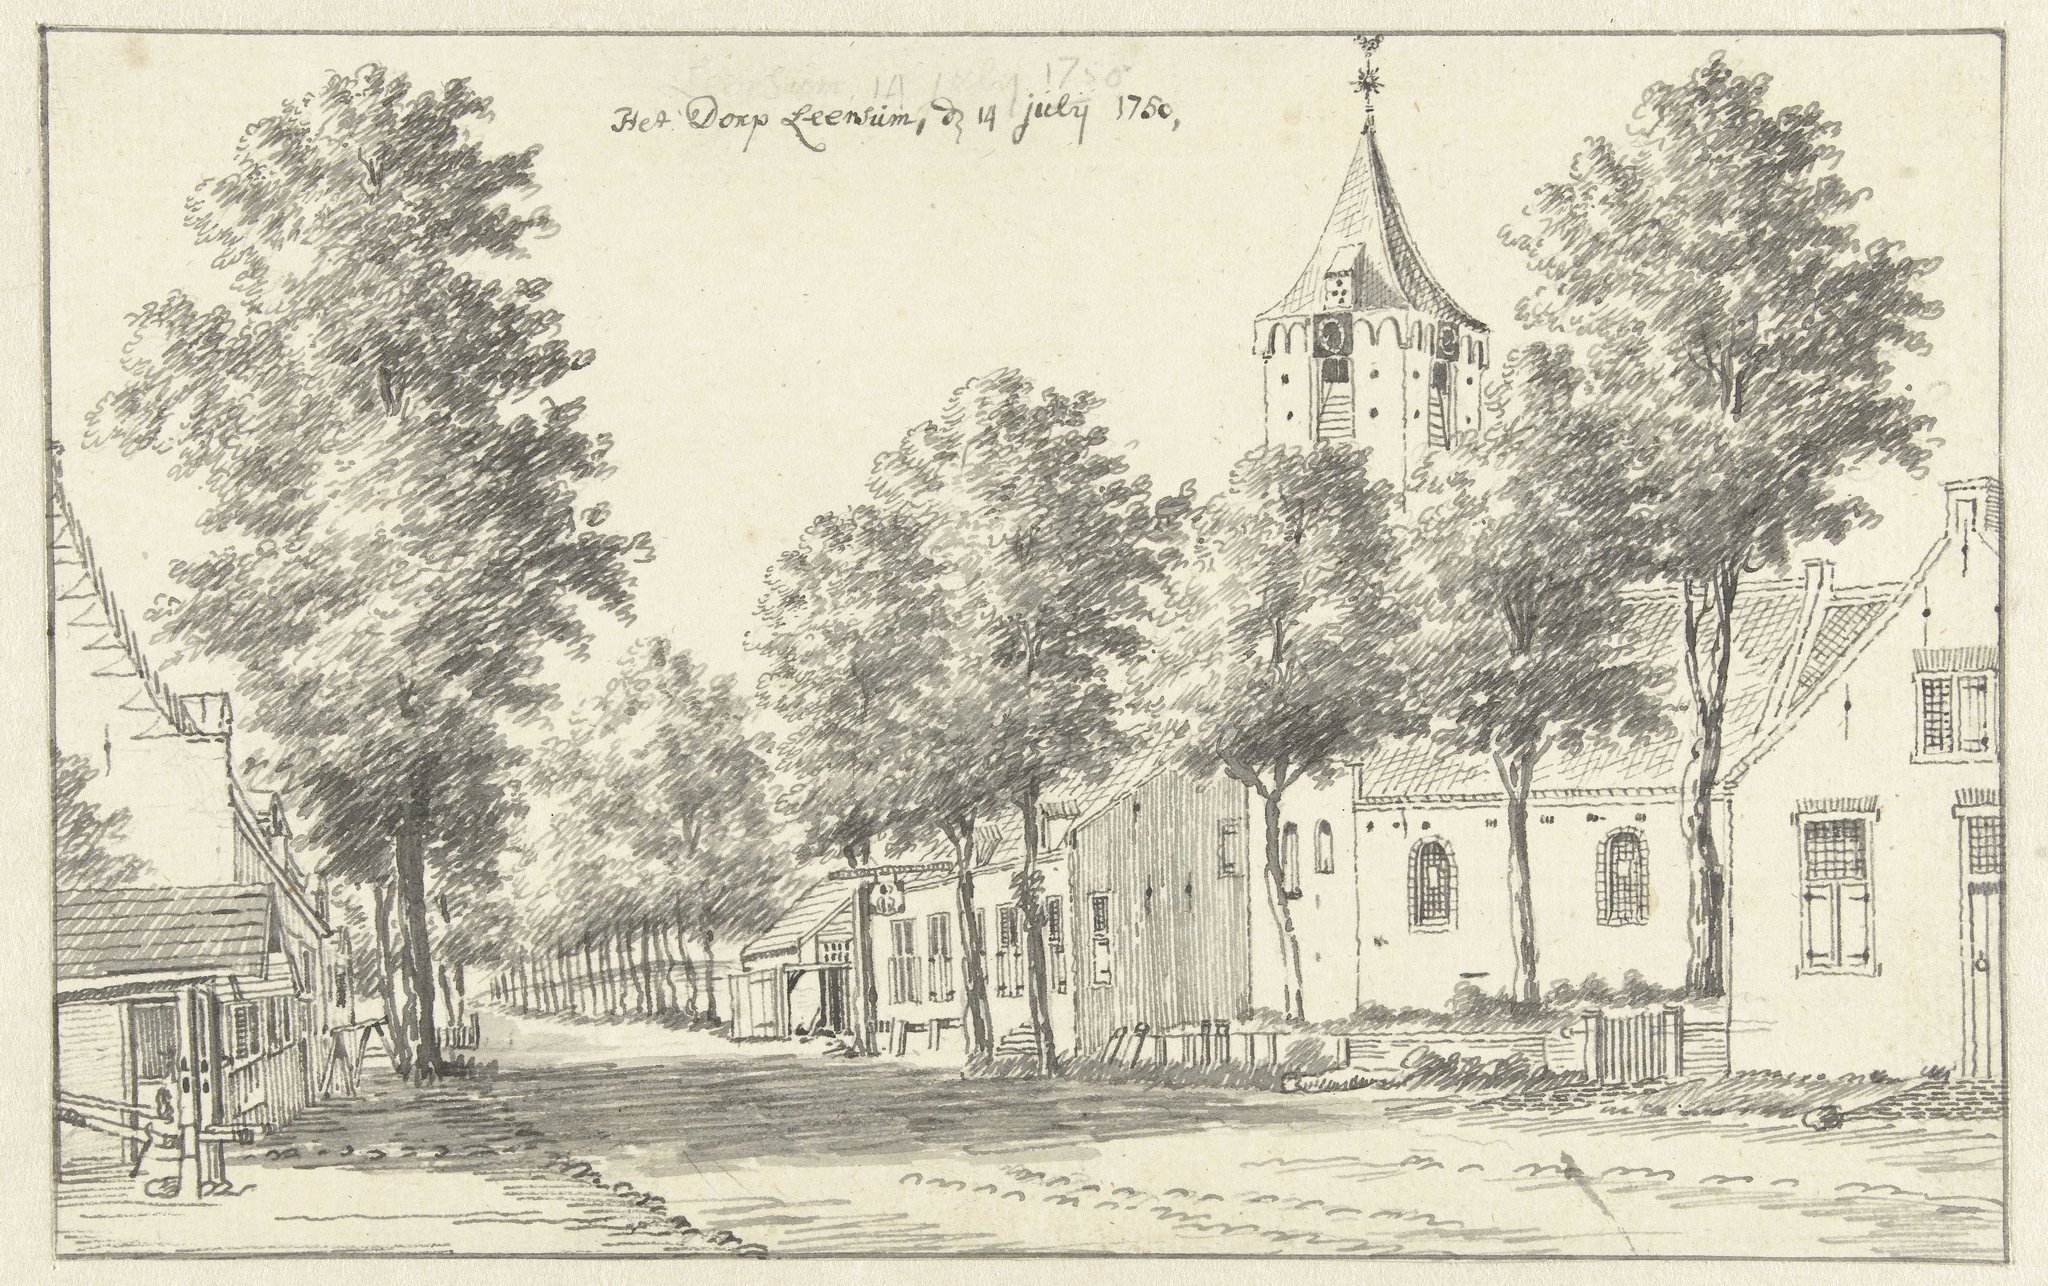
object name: drawing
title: Dorpsstraat te Leersum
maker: jan de beijer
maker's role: draughtsman, print maker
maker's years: 1703-1780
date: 1750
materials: ink, paper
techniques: pen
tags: prospect of city, town panorama, silhouette of city